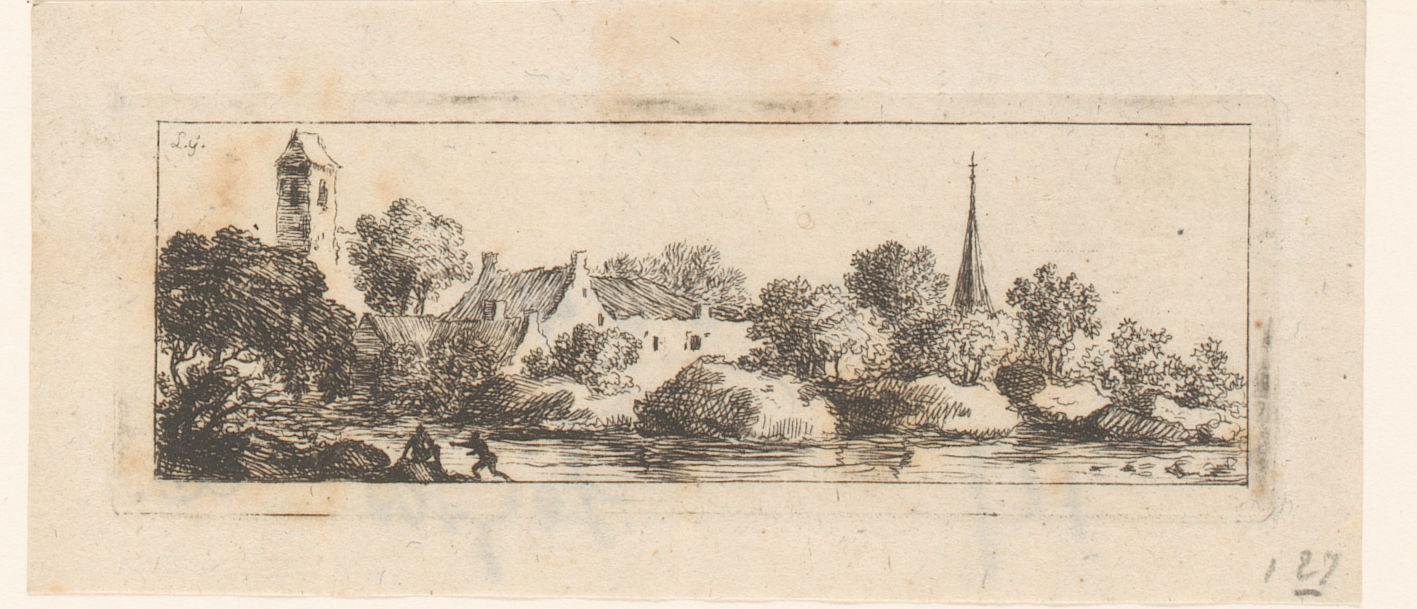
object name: print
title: Gezicht op een dorp aan een rivier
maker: sauveur legros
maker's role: print maker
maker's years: 1754-1834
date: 1764-1834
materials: paper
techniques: etching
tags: outskirts of village, parts of church exterior and annexes: tower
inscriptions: collector's mark: Lugt 2228, collector's mark: Lugt 1485